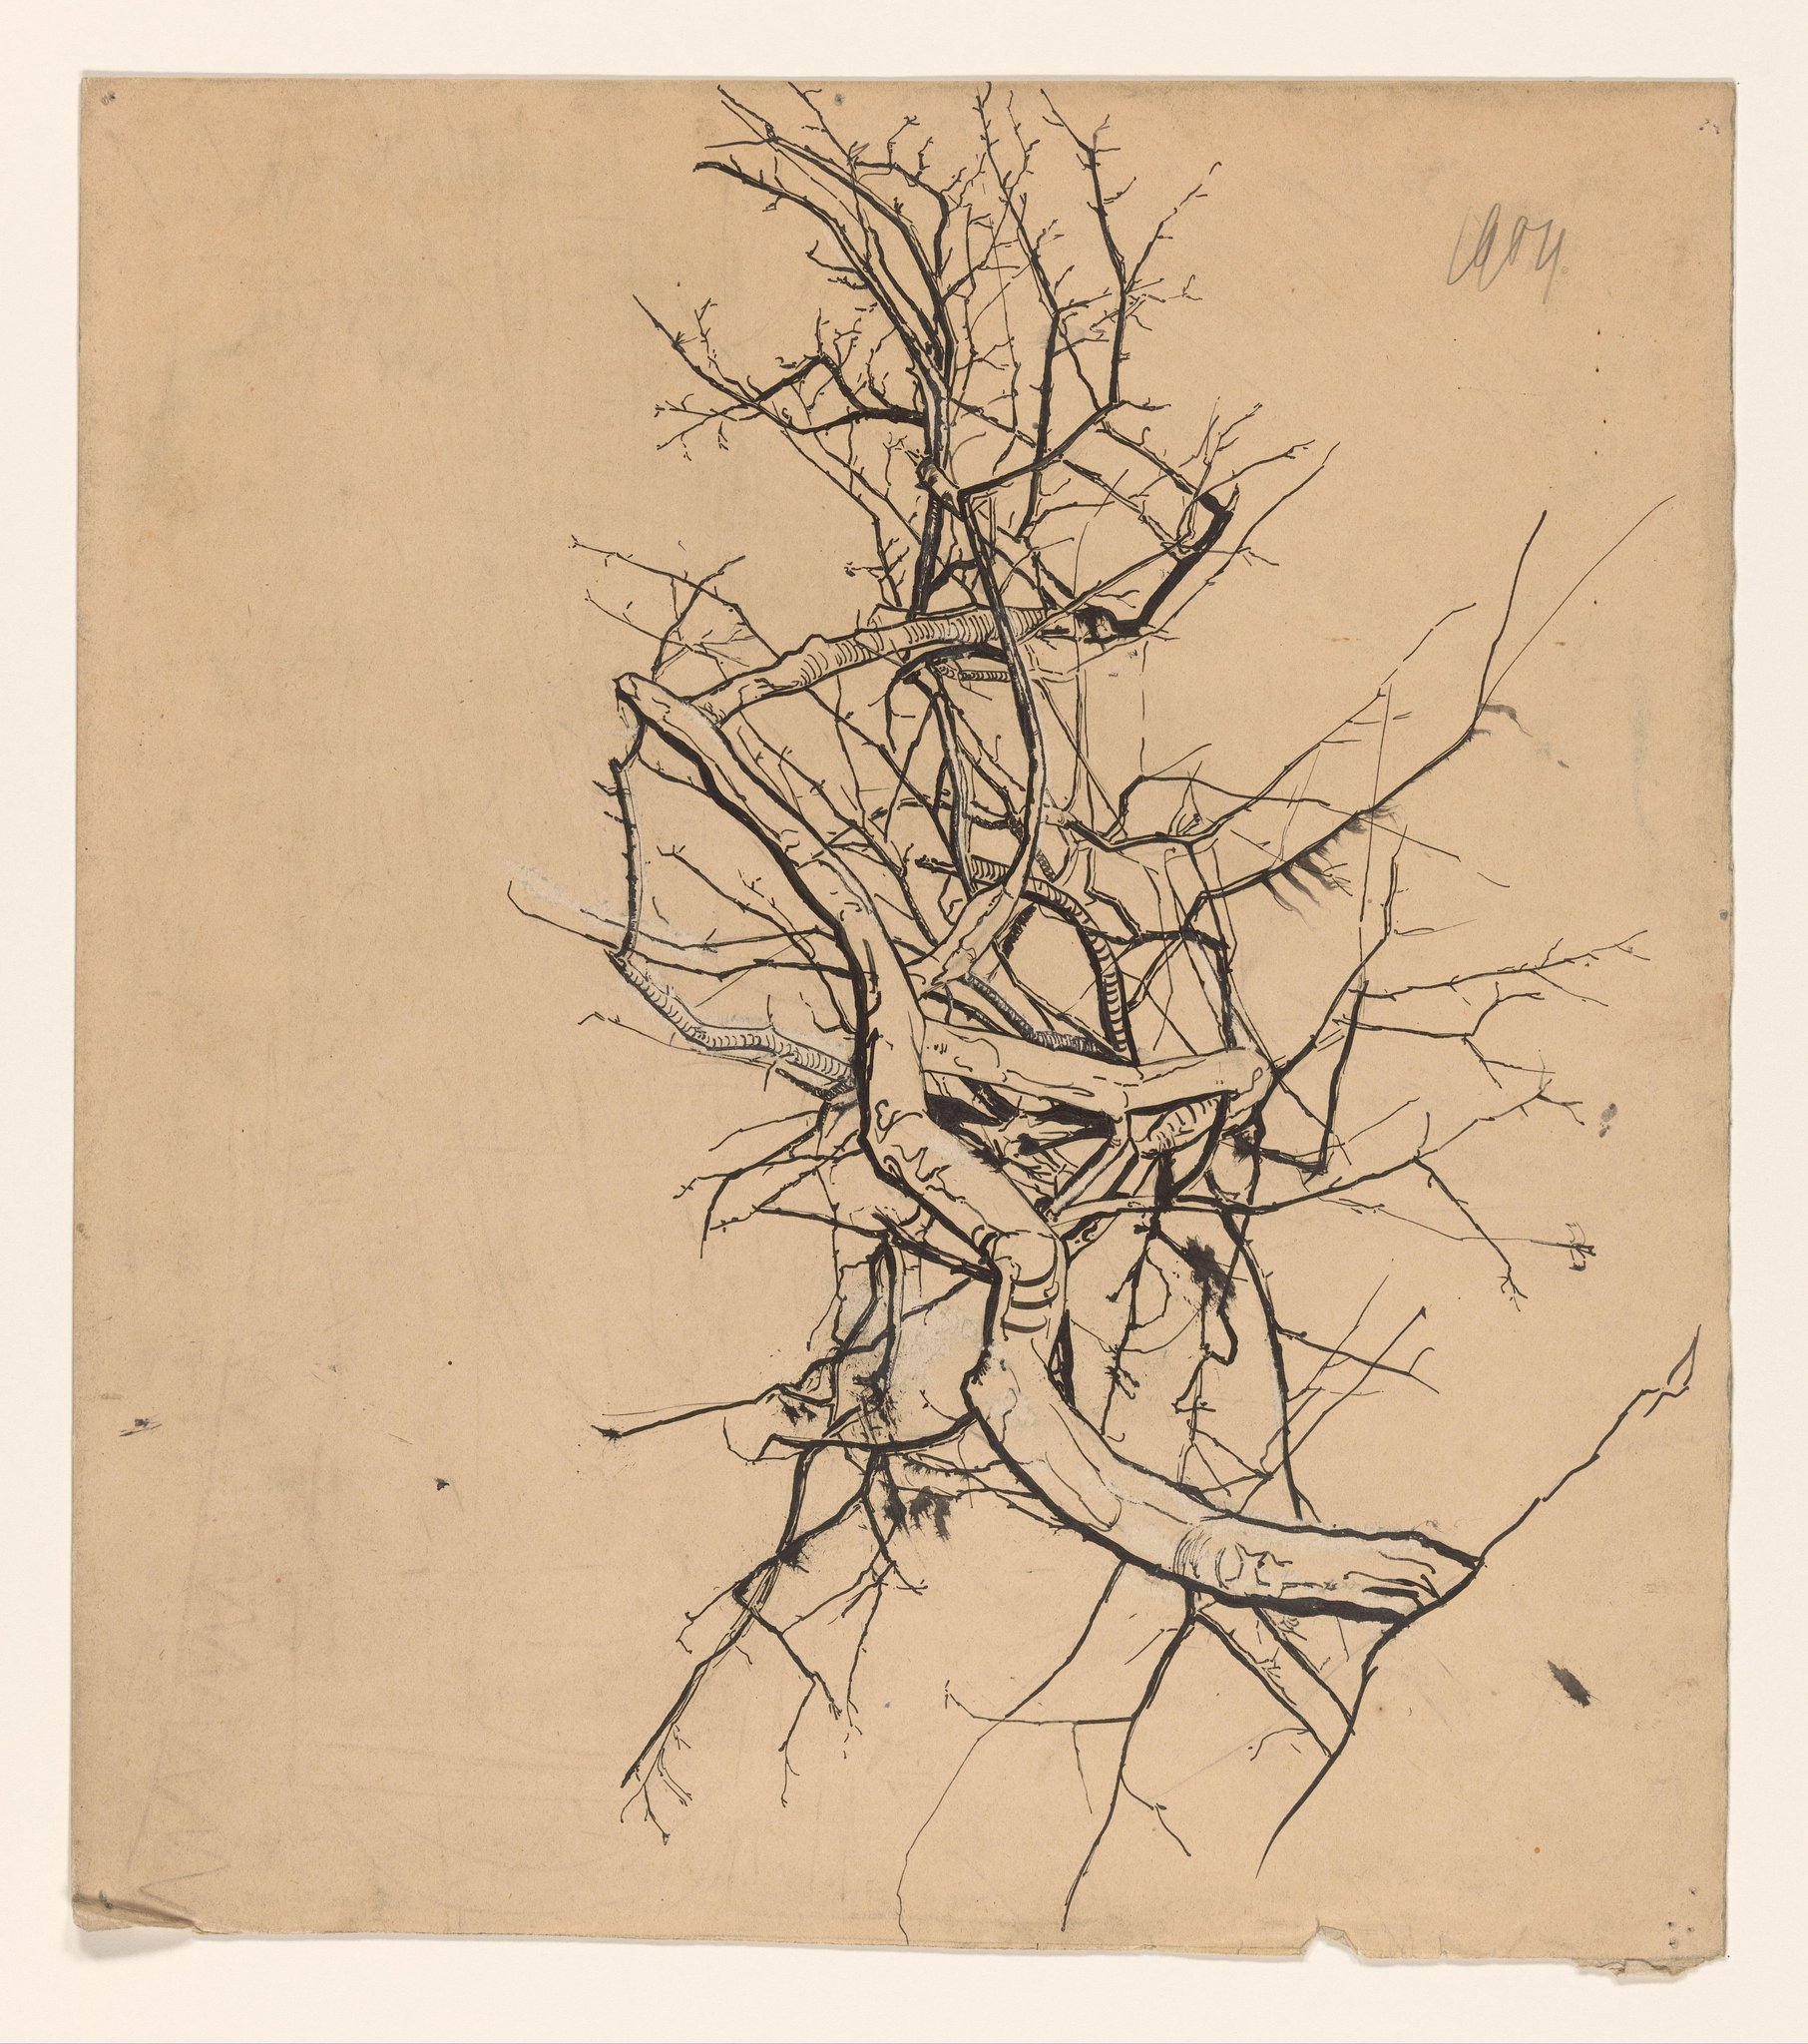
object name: drawing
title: Boomstudie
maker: coba steenhoff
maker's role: draughtsman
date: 1904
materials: ink, paper, pencil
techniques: pen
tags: trees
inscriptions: date: ‘1904’